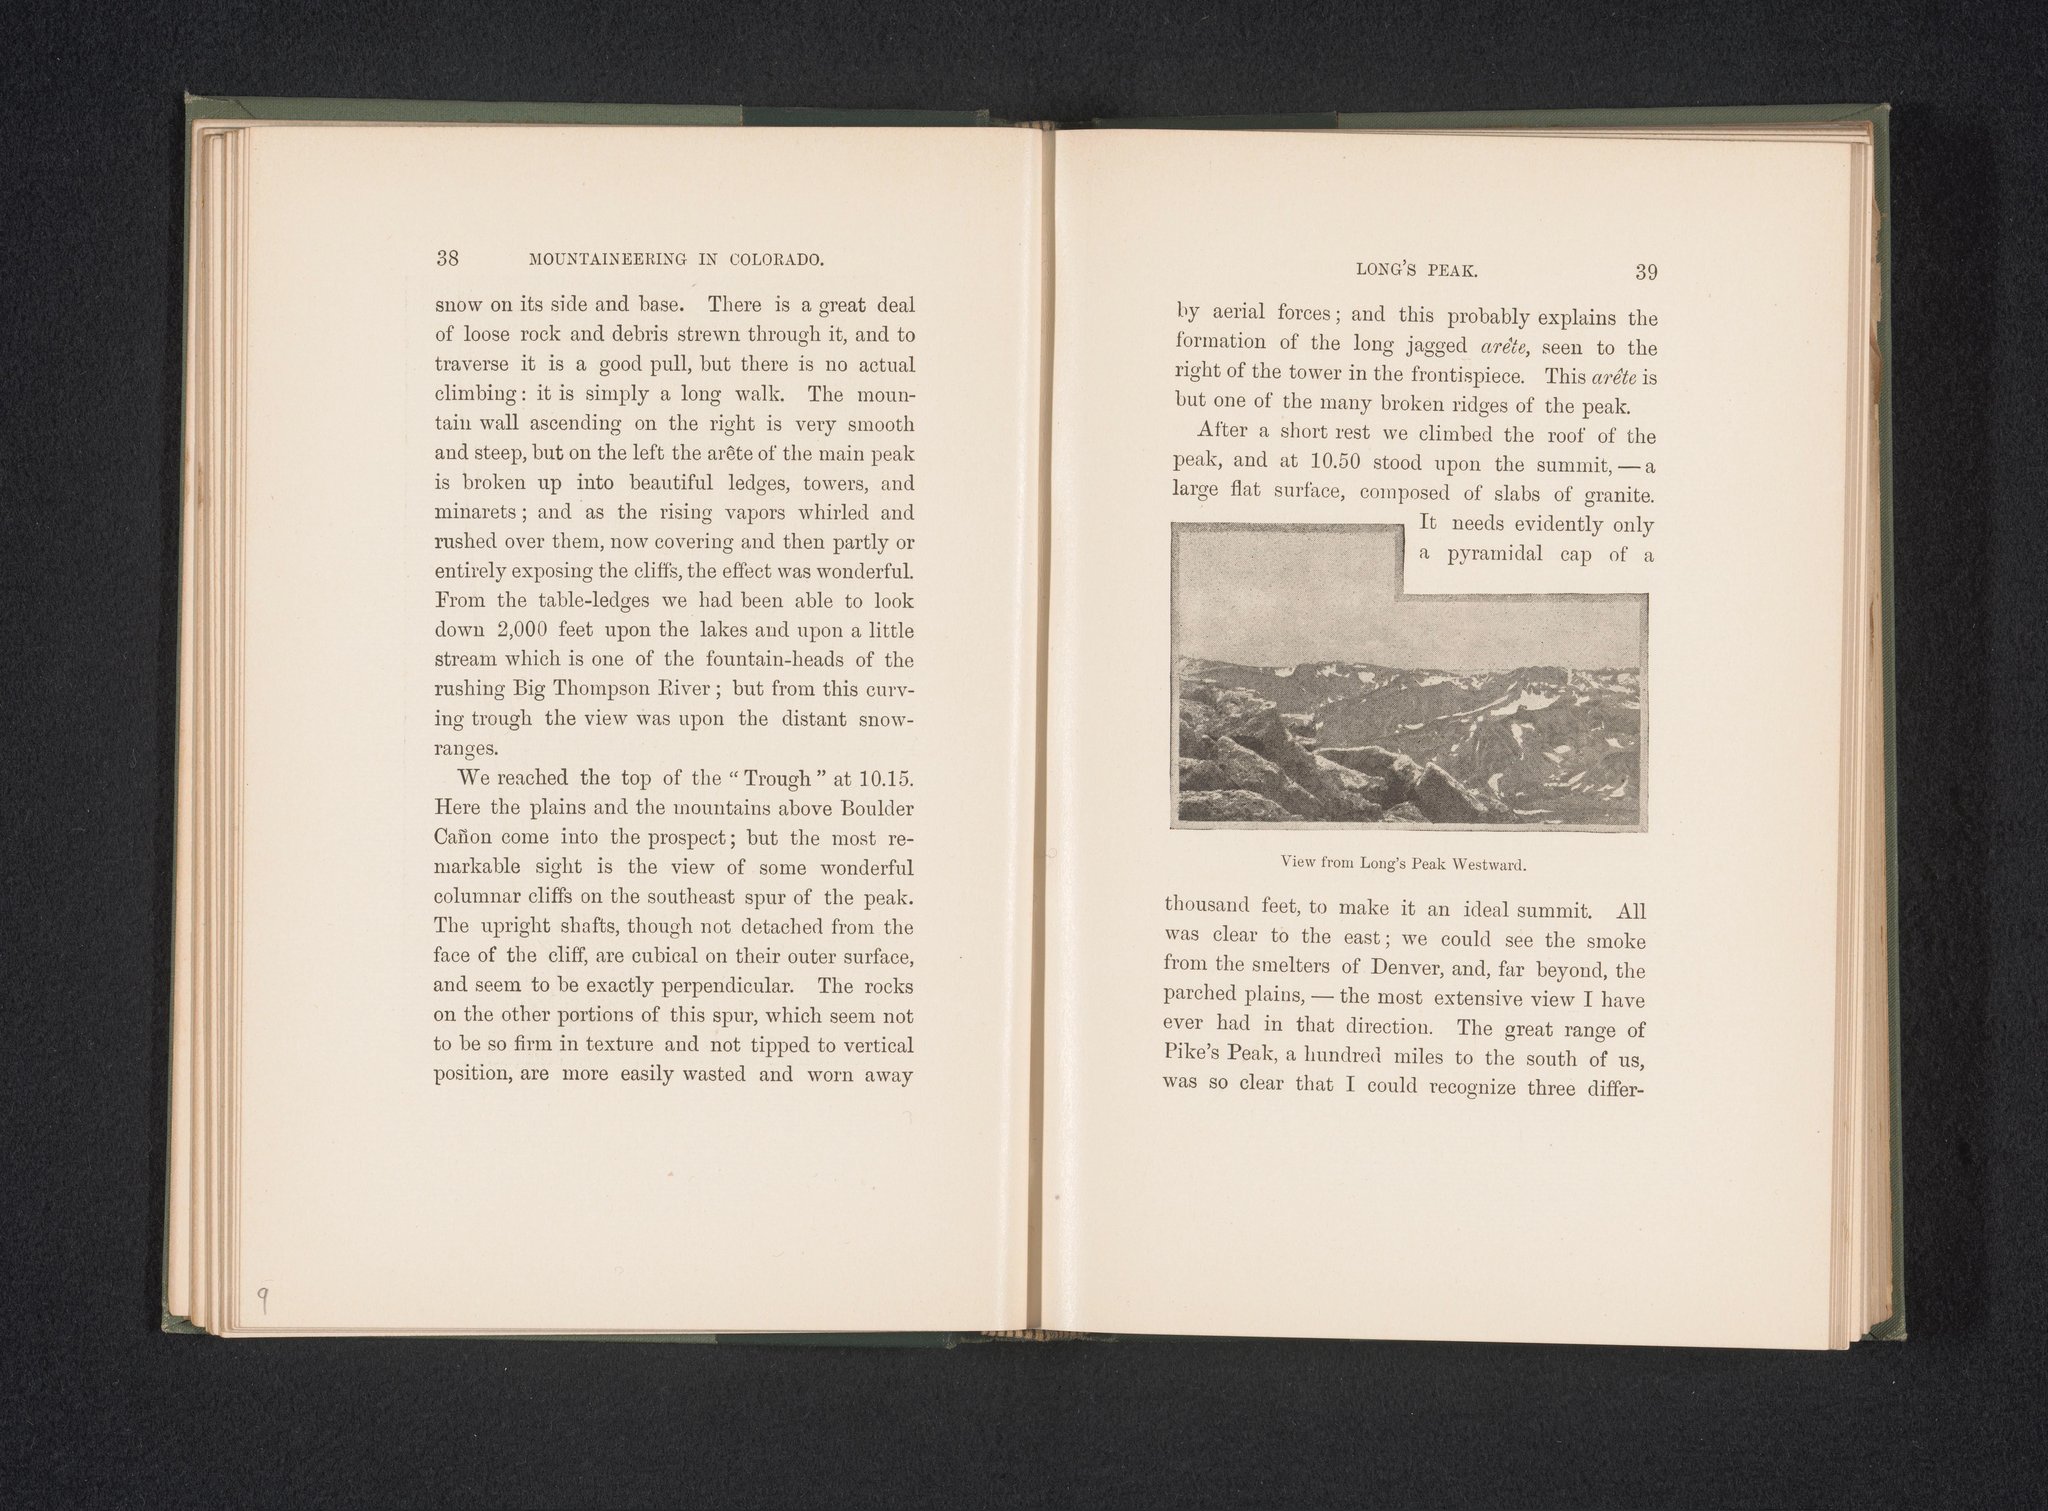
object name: photomechanical print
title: View from Long's Peak Westward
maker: frederick hastings chapin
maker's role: antropoloog, archeoloog, fotograaf, schrijver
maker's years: 1852-1900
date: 1885-1890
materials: paper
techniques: autotype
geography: boston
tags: landscapes, wildlife reserve, national park, mountains